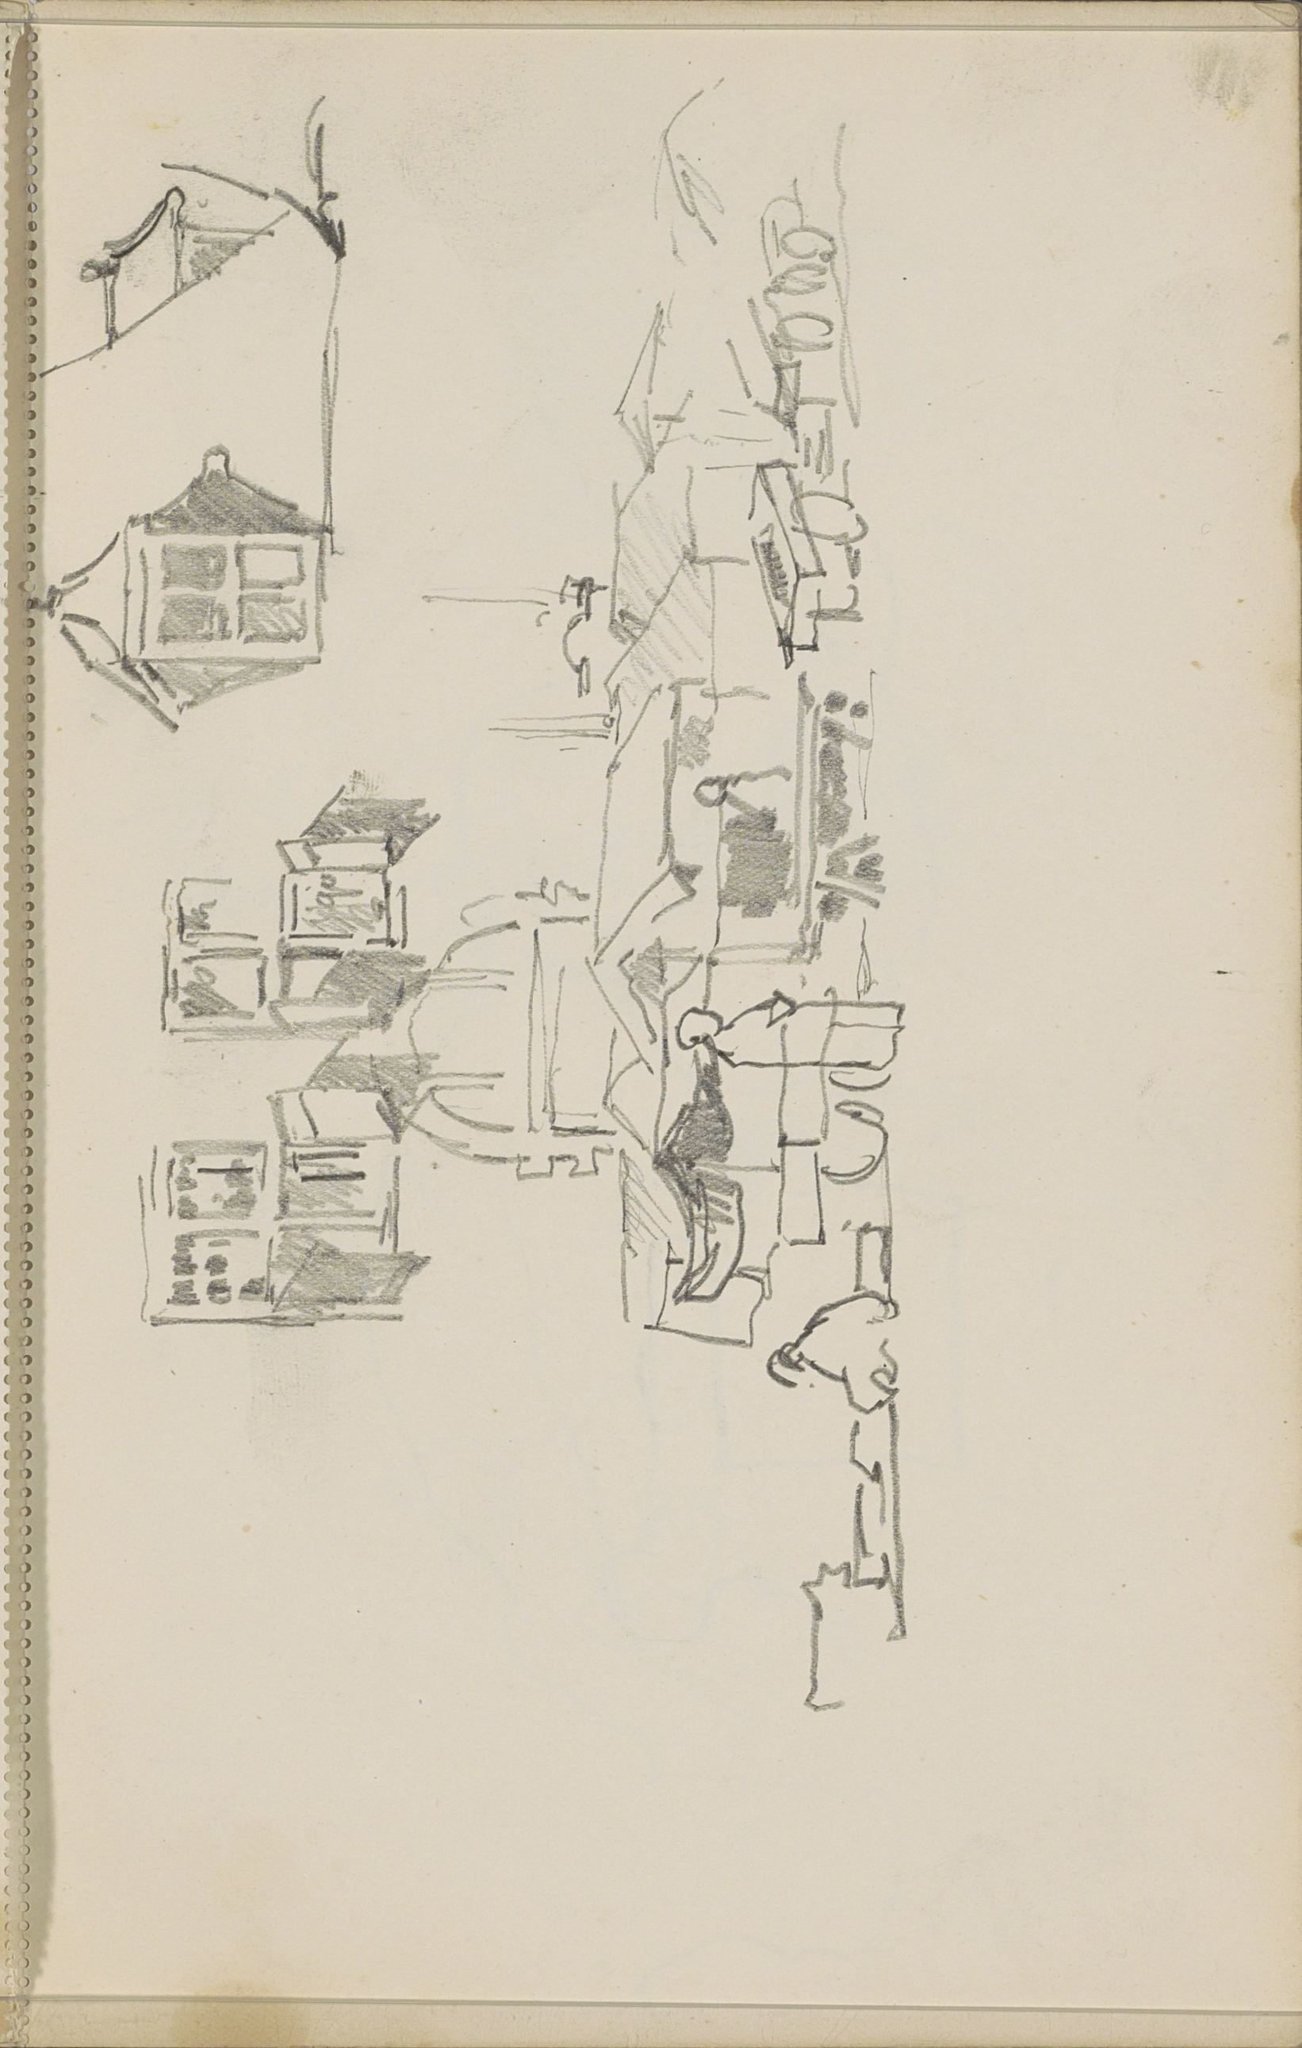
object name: sketchbook leaf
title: Figuren bij marktkramen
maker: cornelis vreedenburgh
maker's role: draughtsman, print maker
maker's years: 1880-1946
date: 1890-1946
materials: paper, pencil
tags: window, stall, booth (~ market)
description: Tevens studies van vensters. Blad 9 recto uit een schetsboek met 59 bladen.